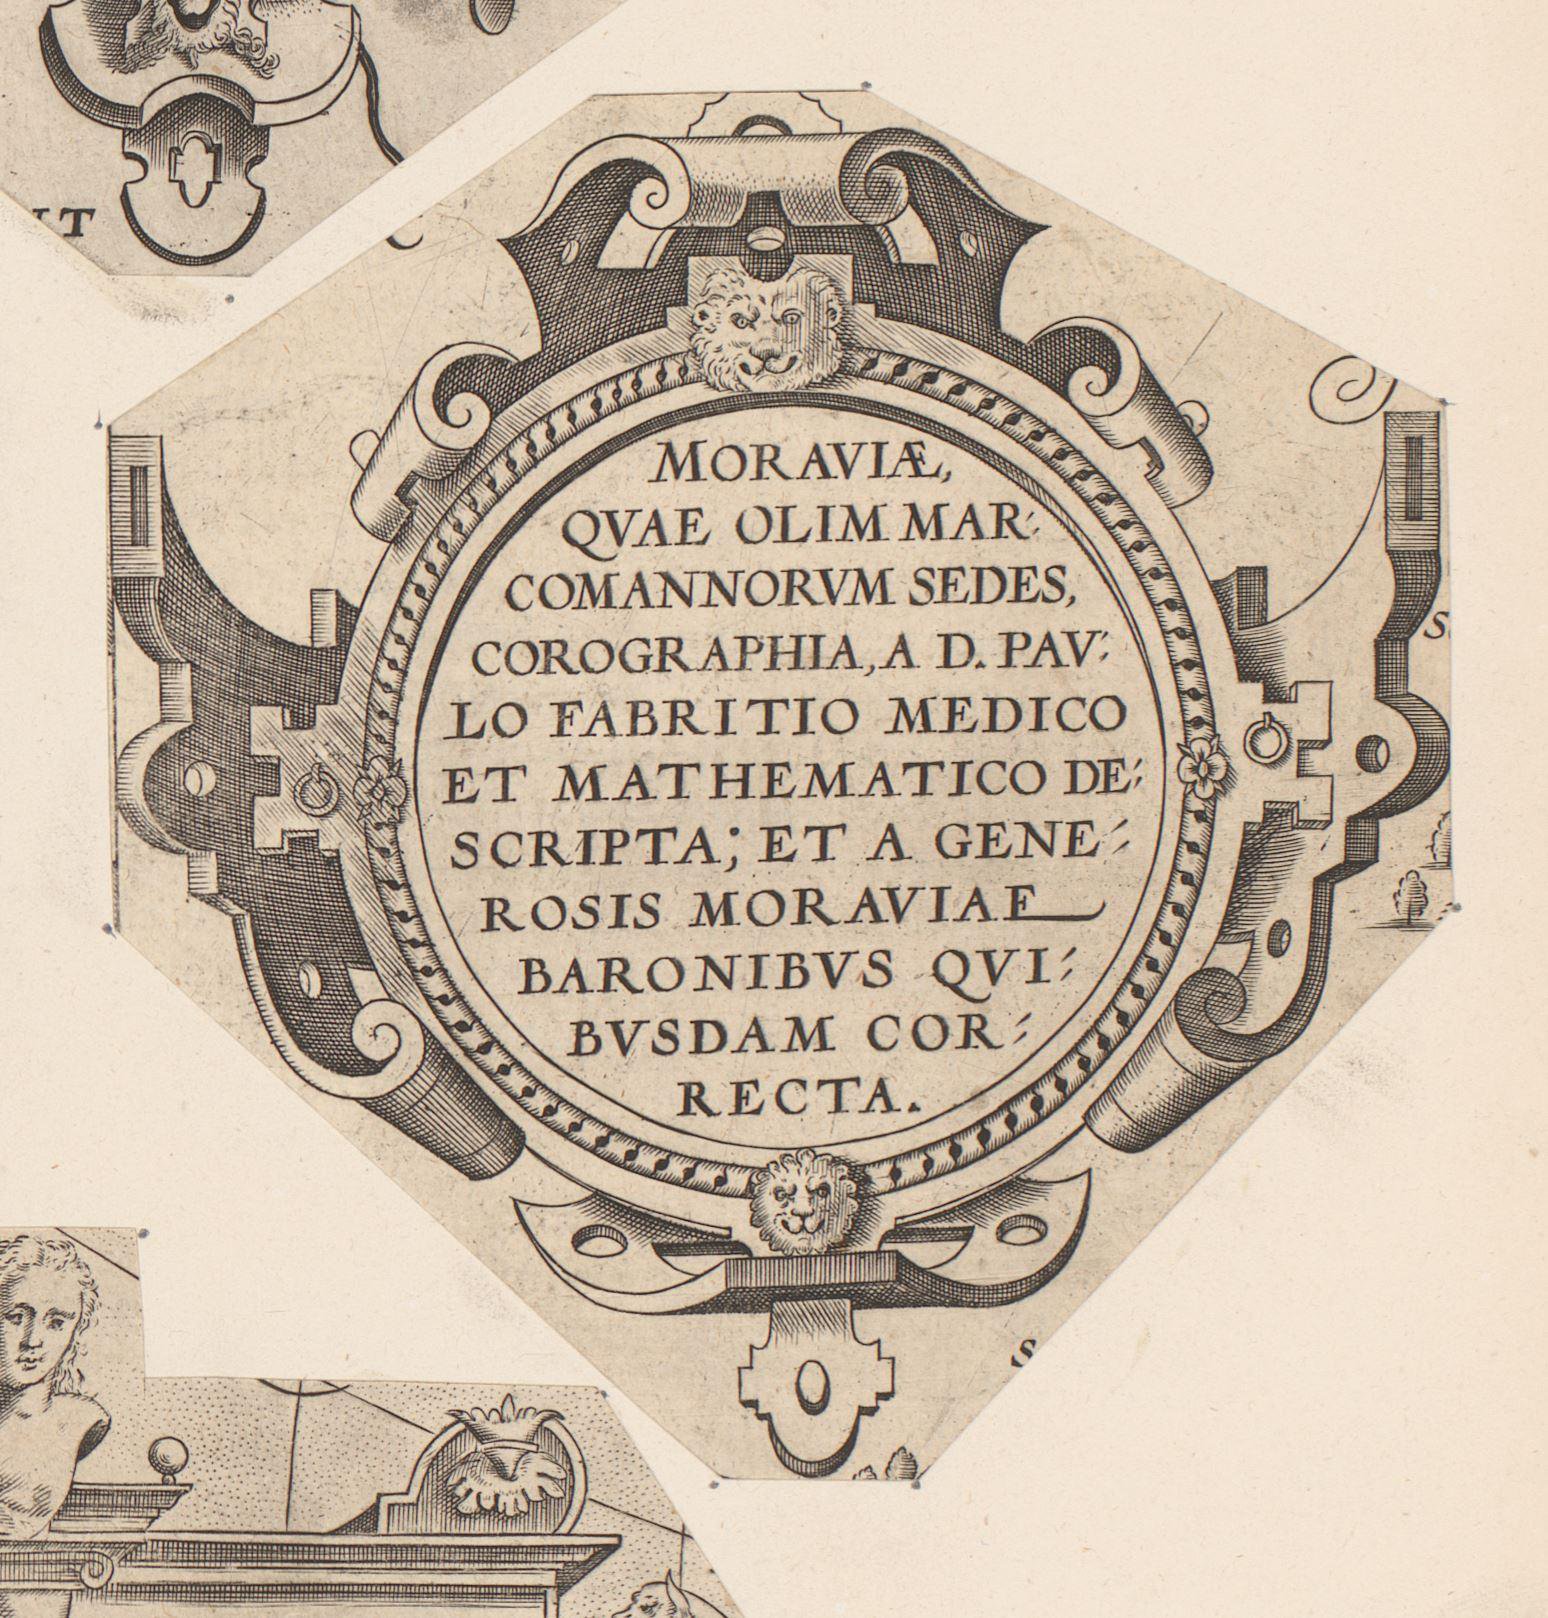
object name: print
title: Theatrum Orbis Terrarum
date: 1573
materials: paper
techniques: engraving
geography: antwerp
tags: ornament ~ cartouche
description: De cartouche is gekopieerd naar een prent van een anonieme graveur naar het ontwerp van Hans Vredeman de Vries, onderdeel van een serie van rolwerkcartouches uit circa 1555-1560.